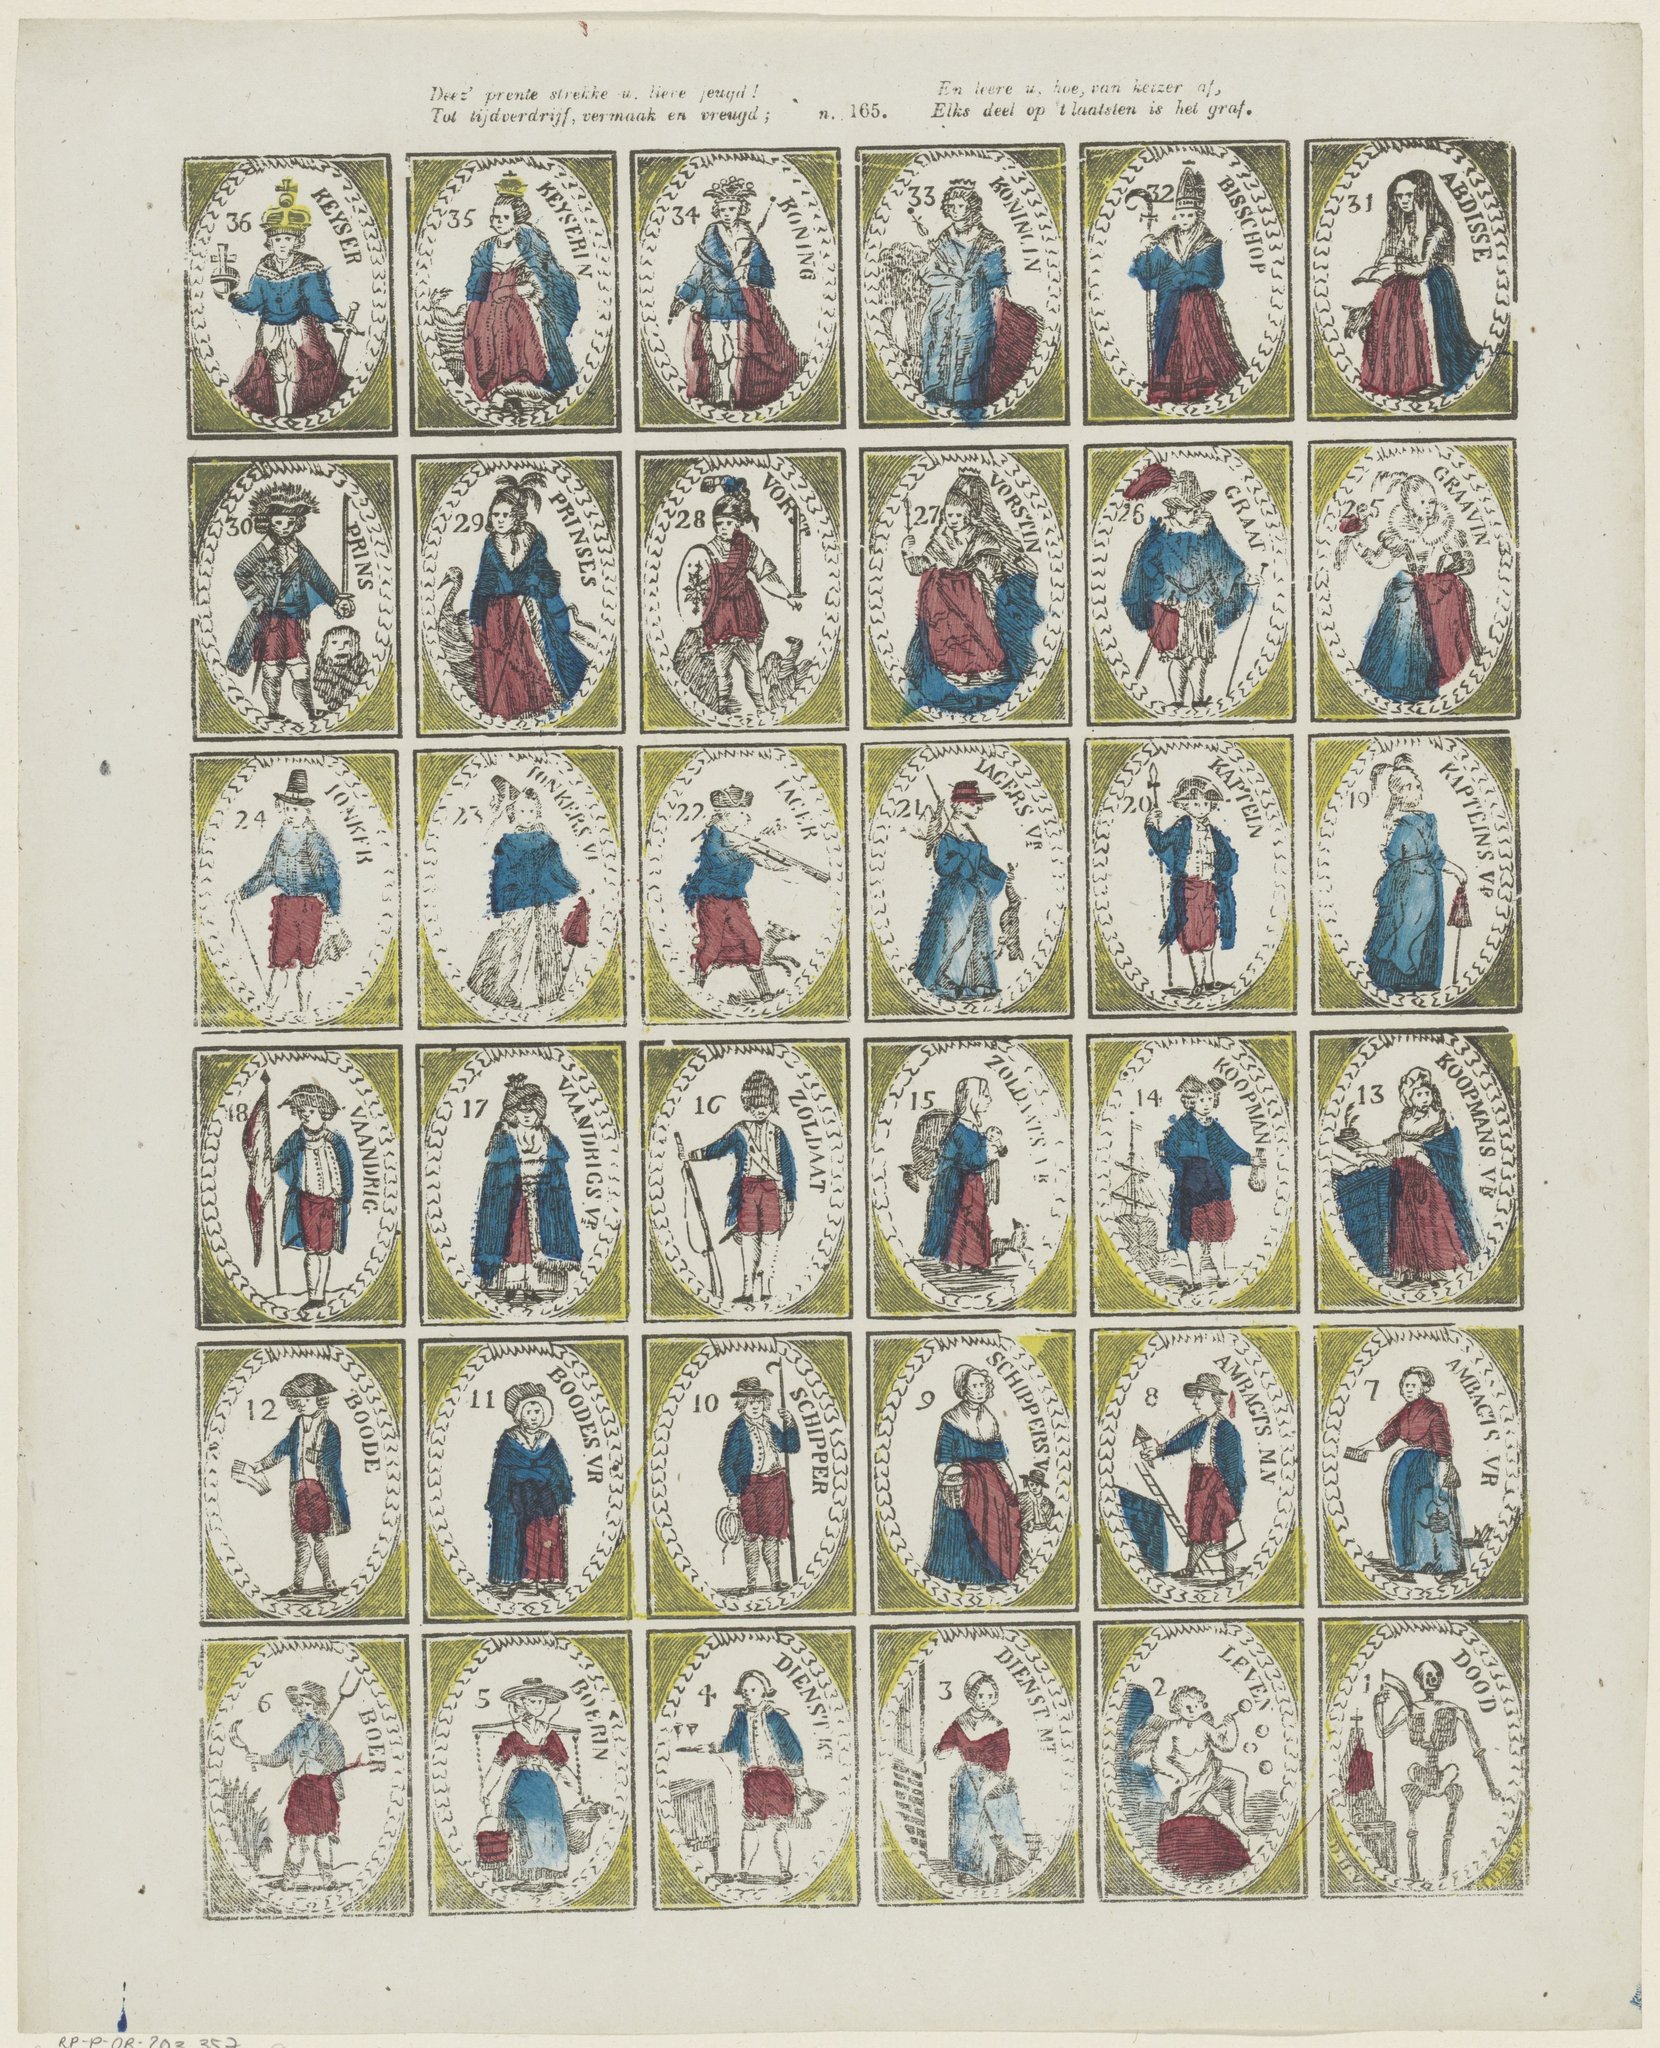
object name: print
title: Deez' prente strekke u, lieve jeugd! / Tot tijdverdrijf, vermaak en vreugd; / En leere u, hoe, van keizer af, / Elke deel op 't laatsten is het graf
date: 1833-1900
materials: paper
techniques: colour, letterpress printing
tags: symbols and personifications of death, social position, playing-cards, nobility and patriciate; chivalry, knighthood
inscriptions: collector's mark: Lugt 2760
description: Blad met 36 speelkaarten (floskaartjes) met voorstellingen van verschillende figuren. De afbeeldingen vormen achttien paren, aflopend genummerd van bovenaan links nummer 36 tot onderaan rechts nummer 1. Op de twee laagste nummers na tonen ze zeventien koppels, man en vrouw, met de man net één nummer hoger dan de vrouw, waarbij elk paar een beroep of een maatschappelijke positie voorstelt. Genummerd midden boven: n. 165.